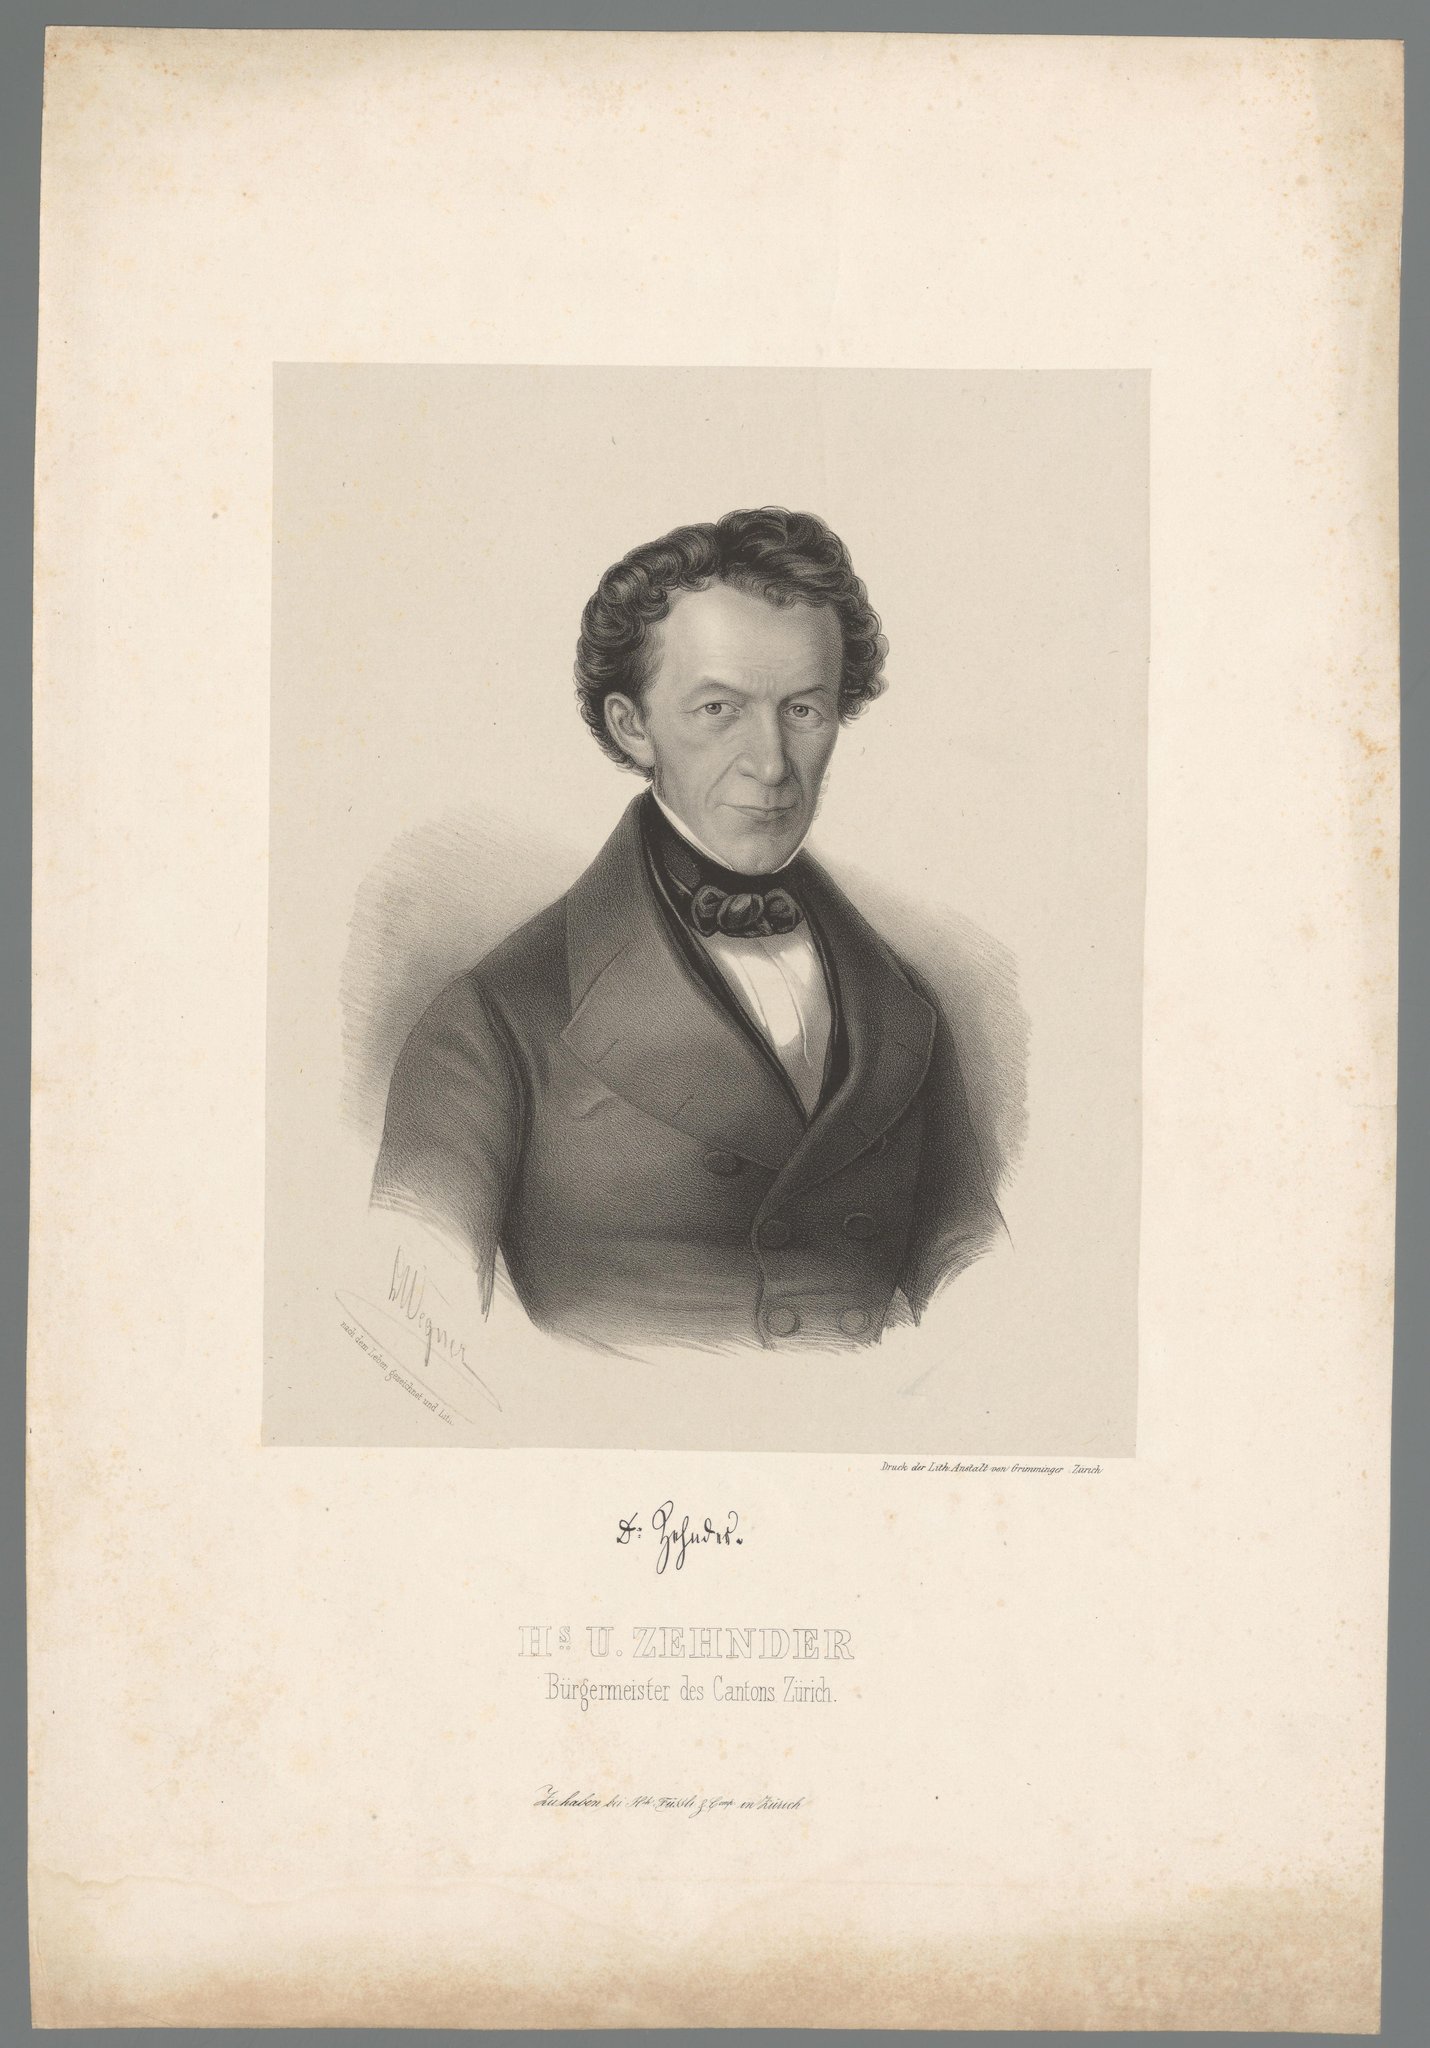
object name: print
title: Portret van Hans Ulrich Zehnder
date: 1826-1864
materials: paper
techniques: lithograph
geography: zurich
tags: adult man, historical persons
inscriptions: collector's mark: Lugt 2228